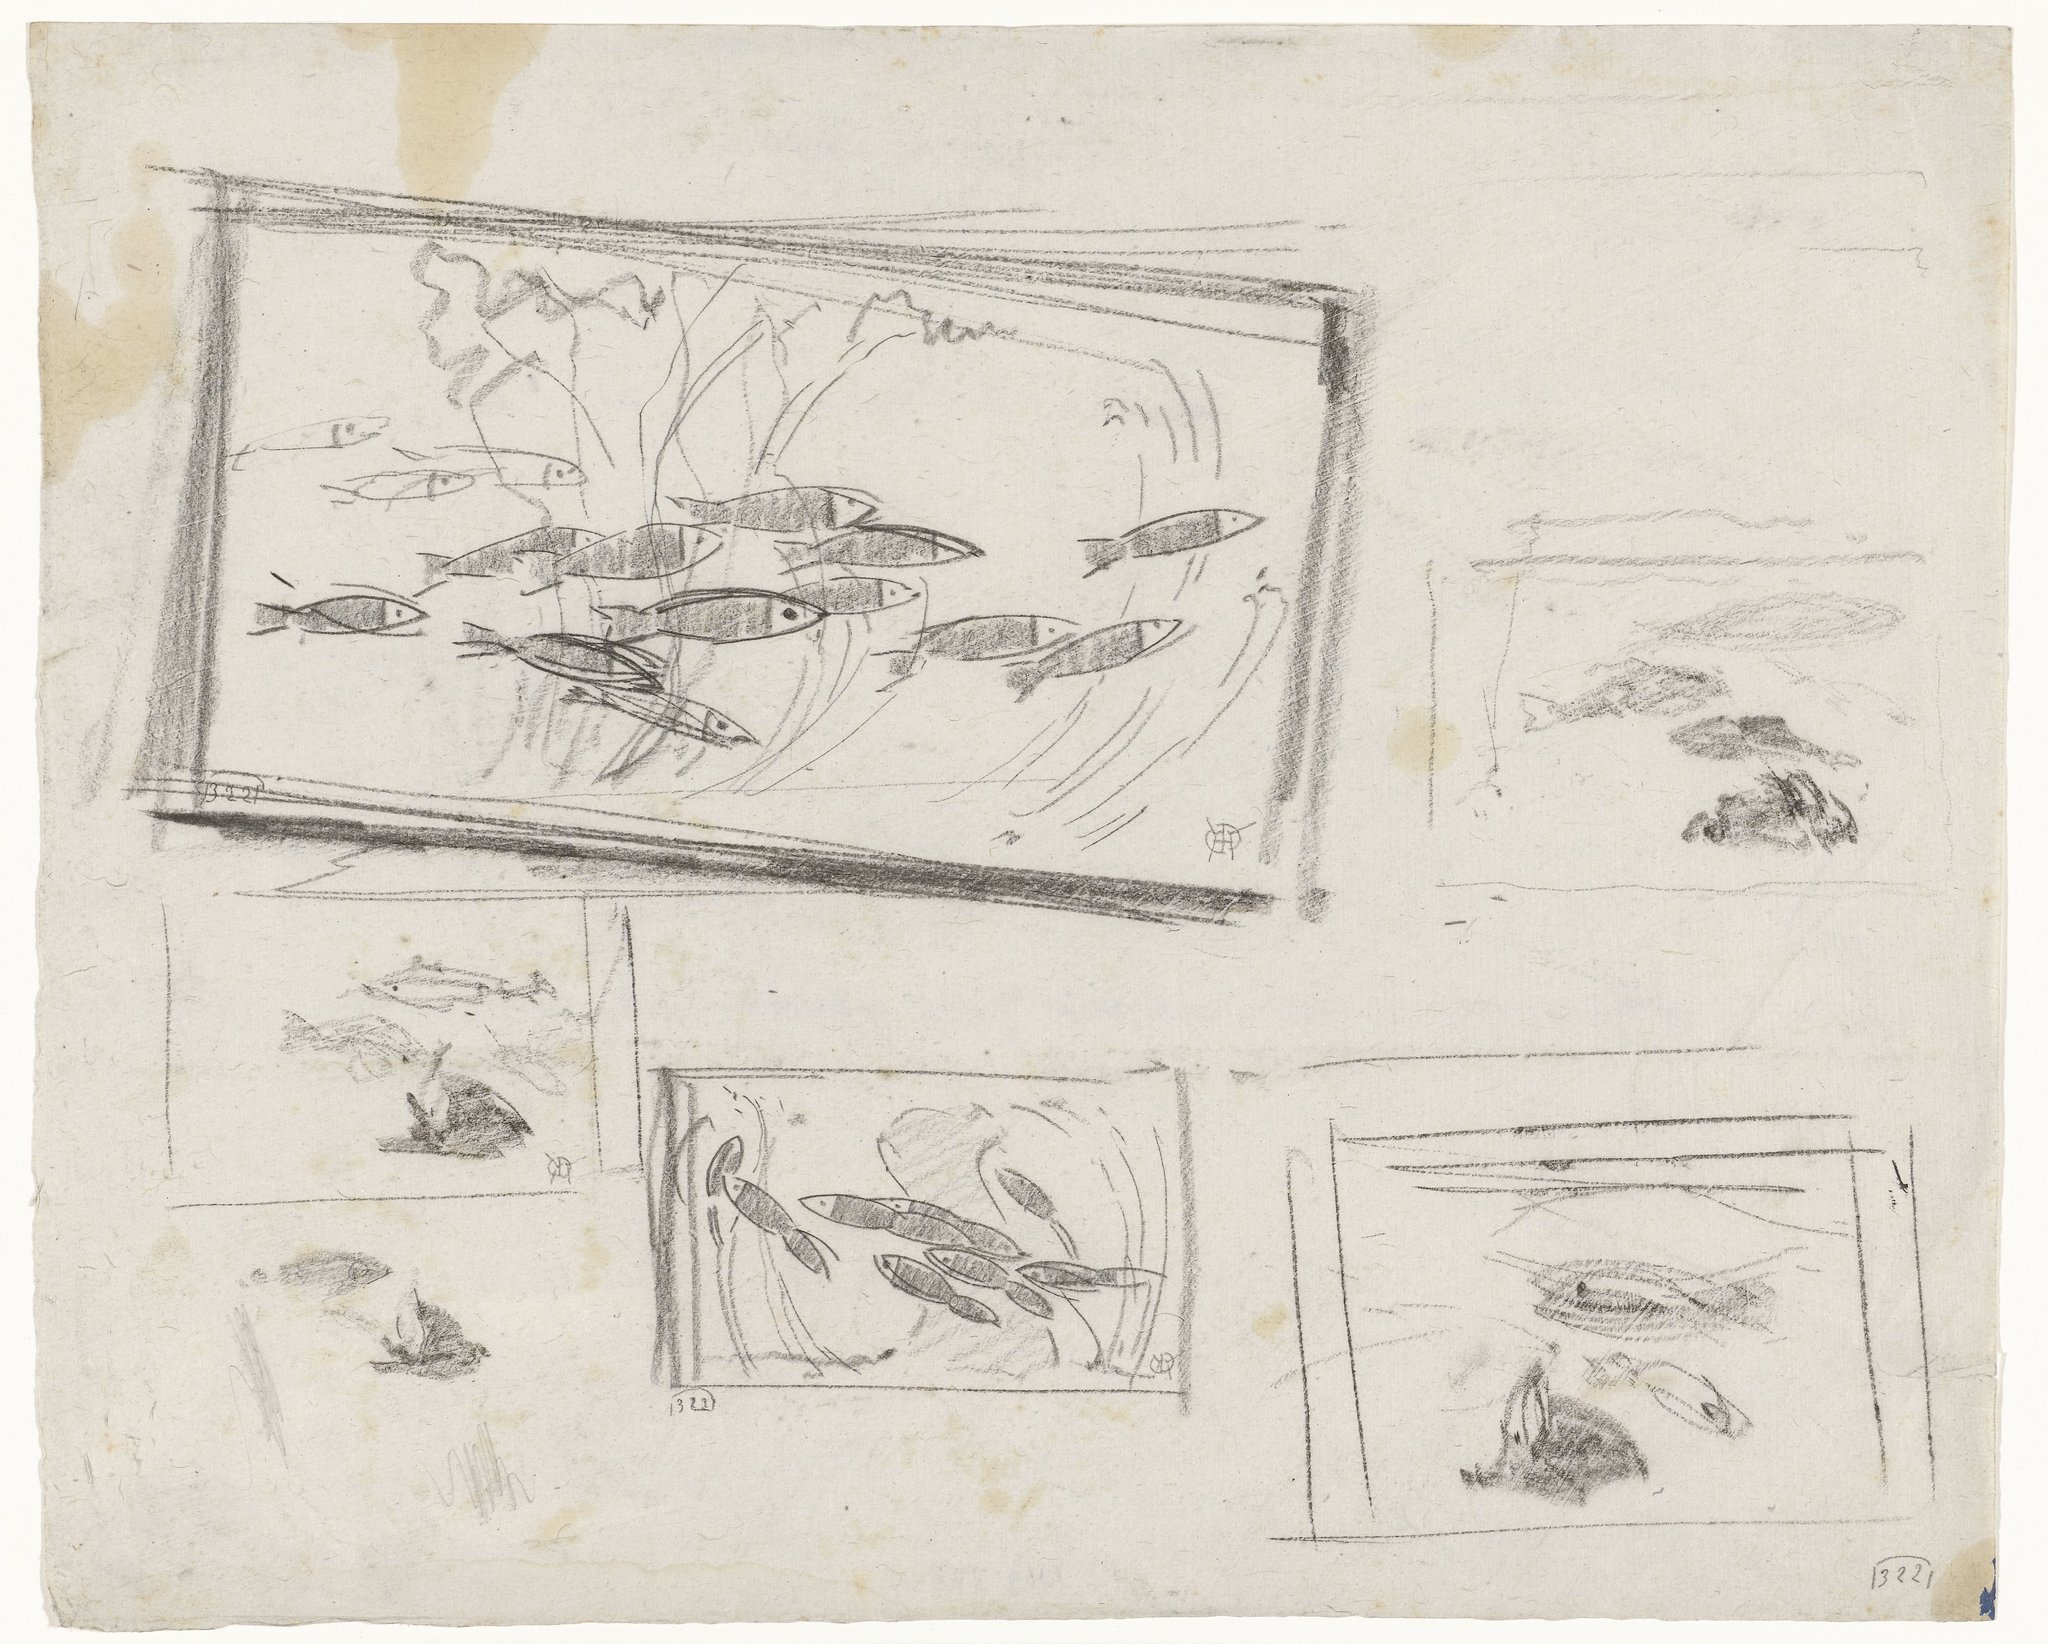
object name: drawing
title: Compositiestudies van vissen in een aquarium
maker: gerrit willem dijsselhof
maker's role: designer, draughtsman, print maker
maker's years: 1866-1924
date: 1876-1924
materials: chalk, paper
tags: aquarium, bony fishes